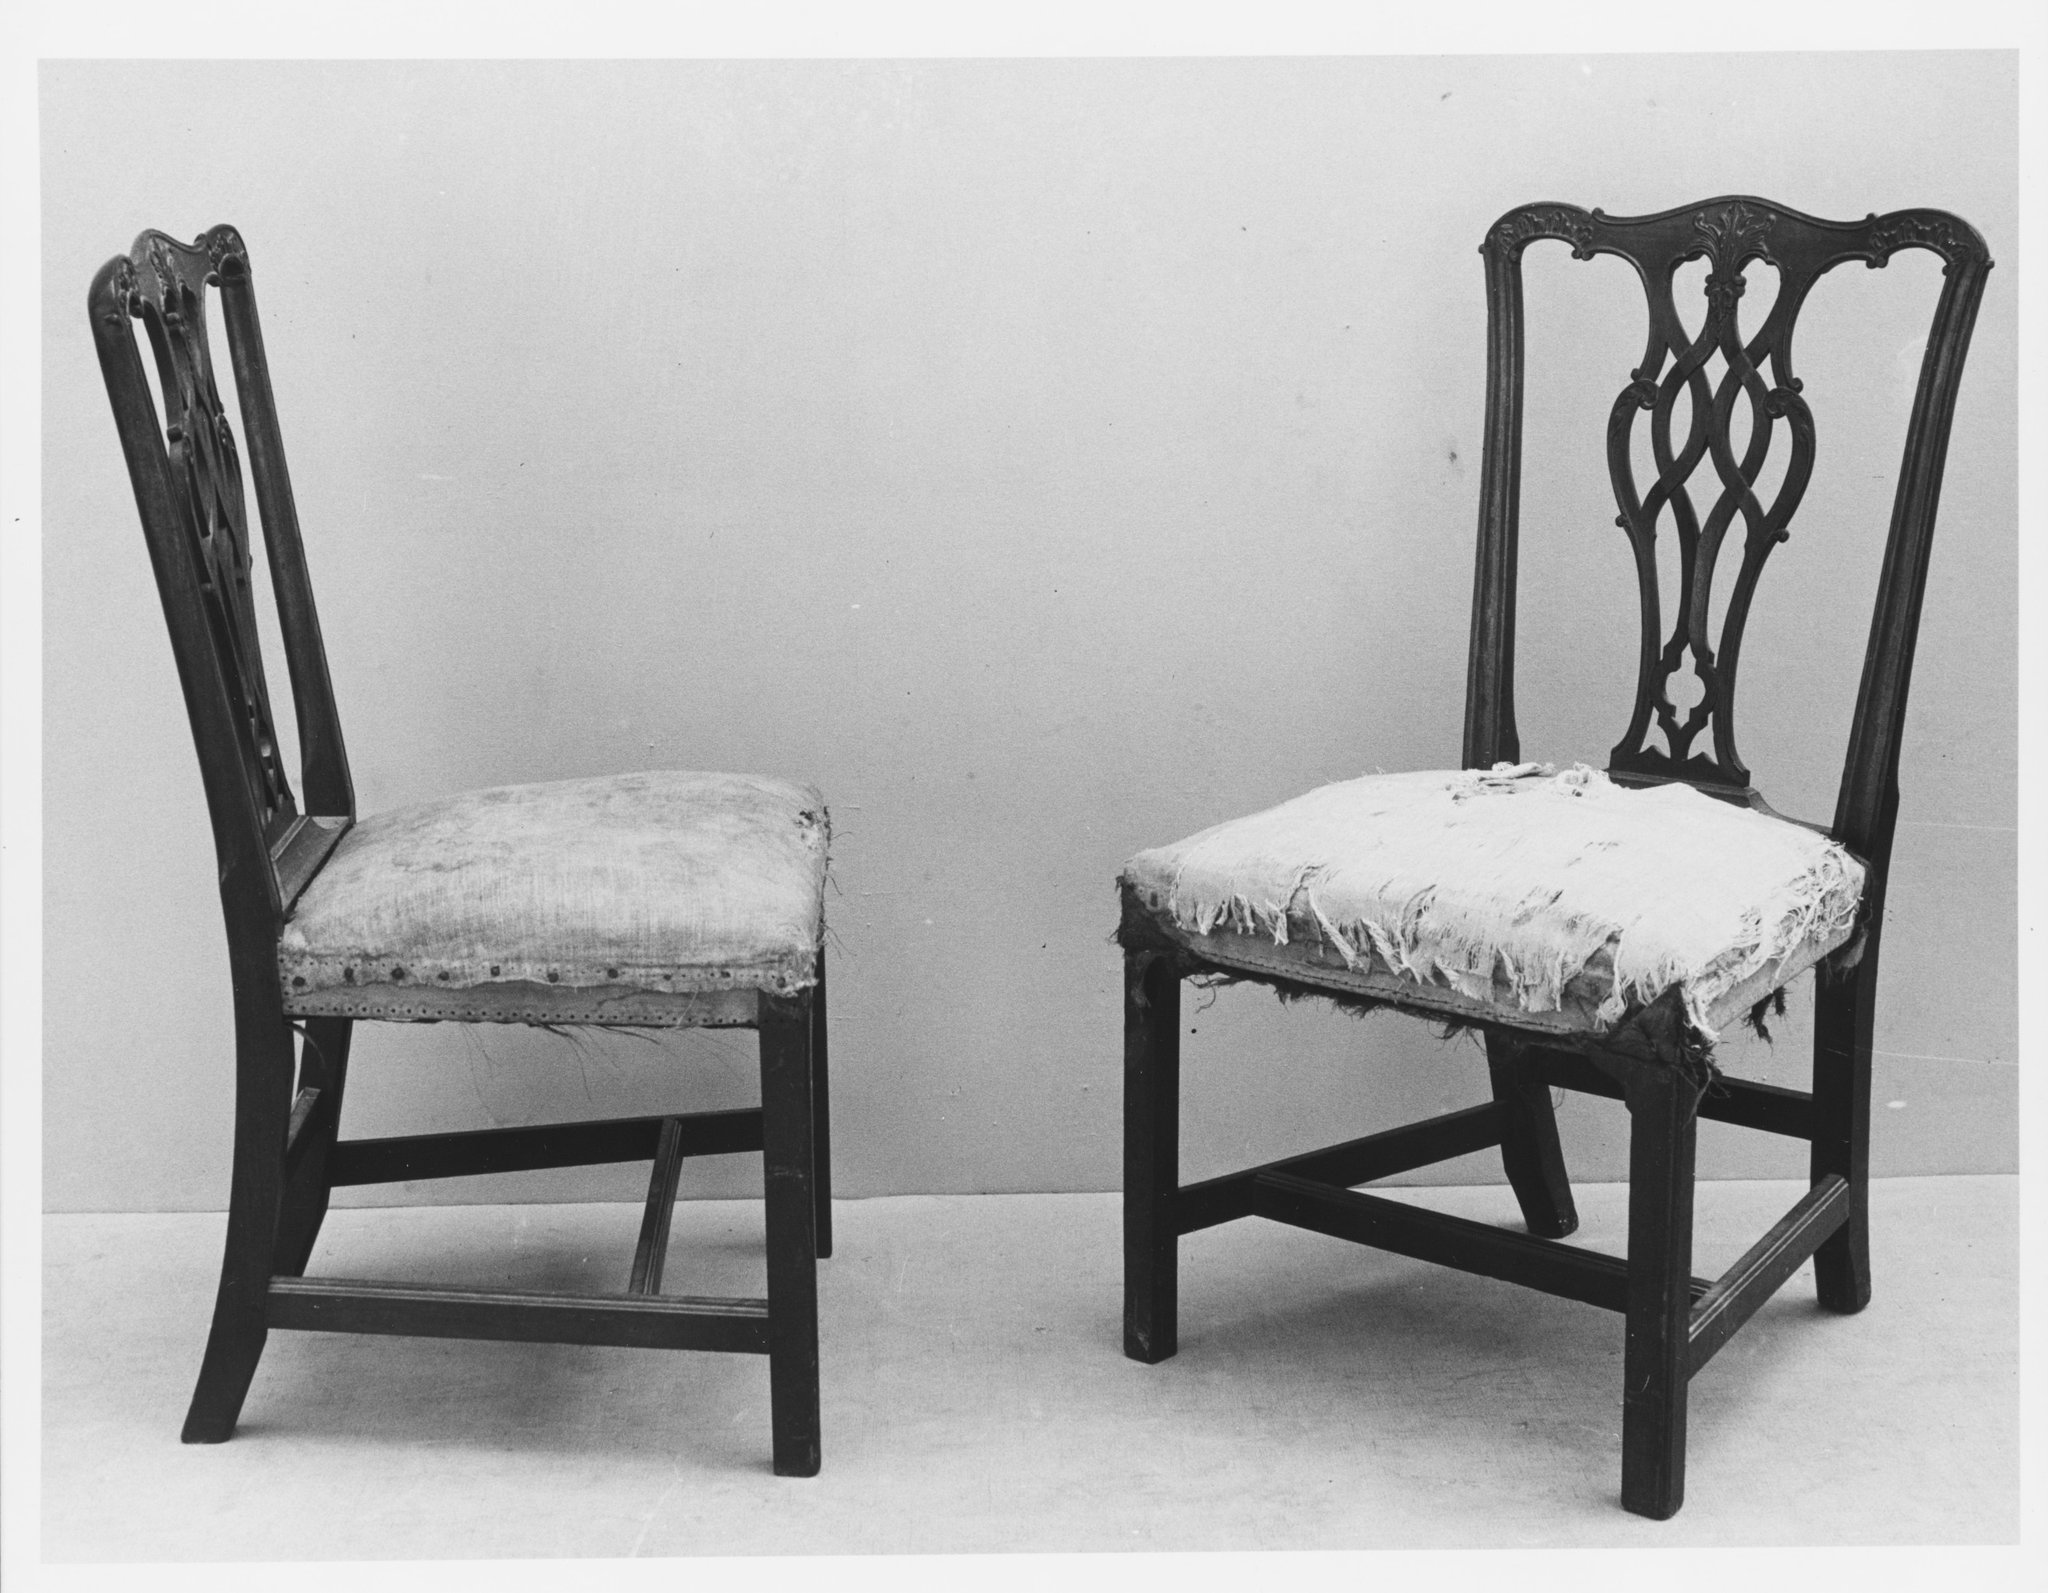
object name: side chair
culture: american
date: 1760-1790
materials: wood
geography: united states